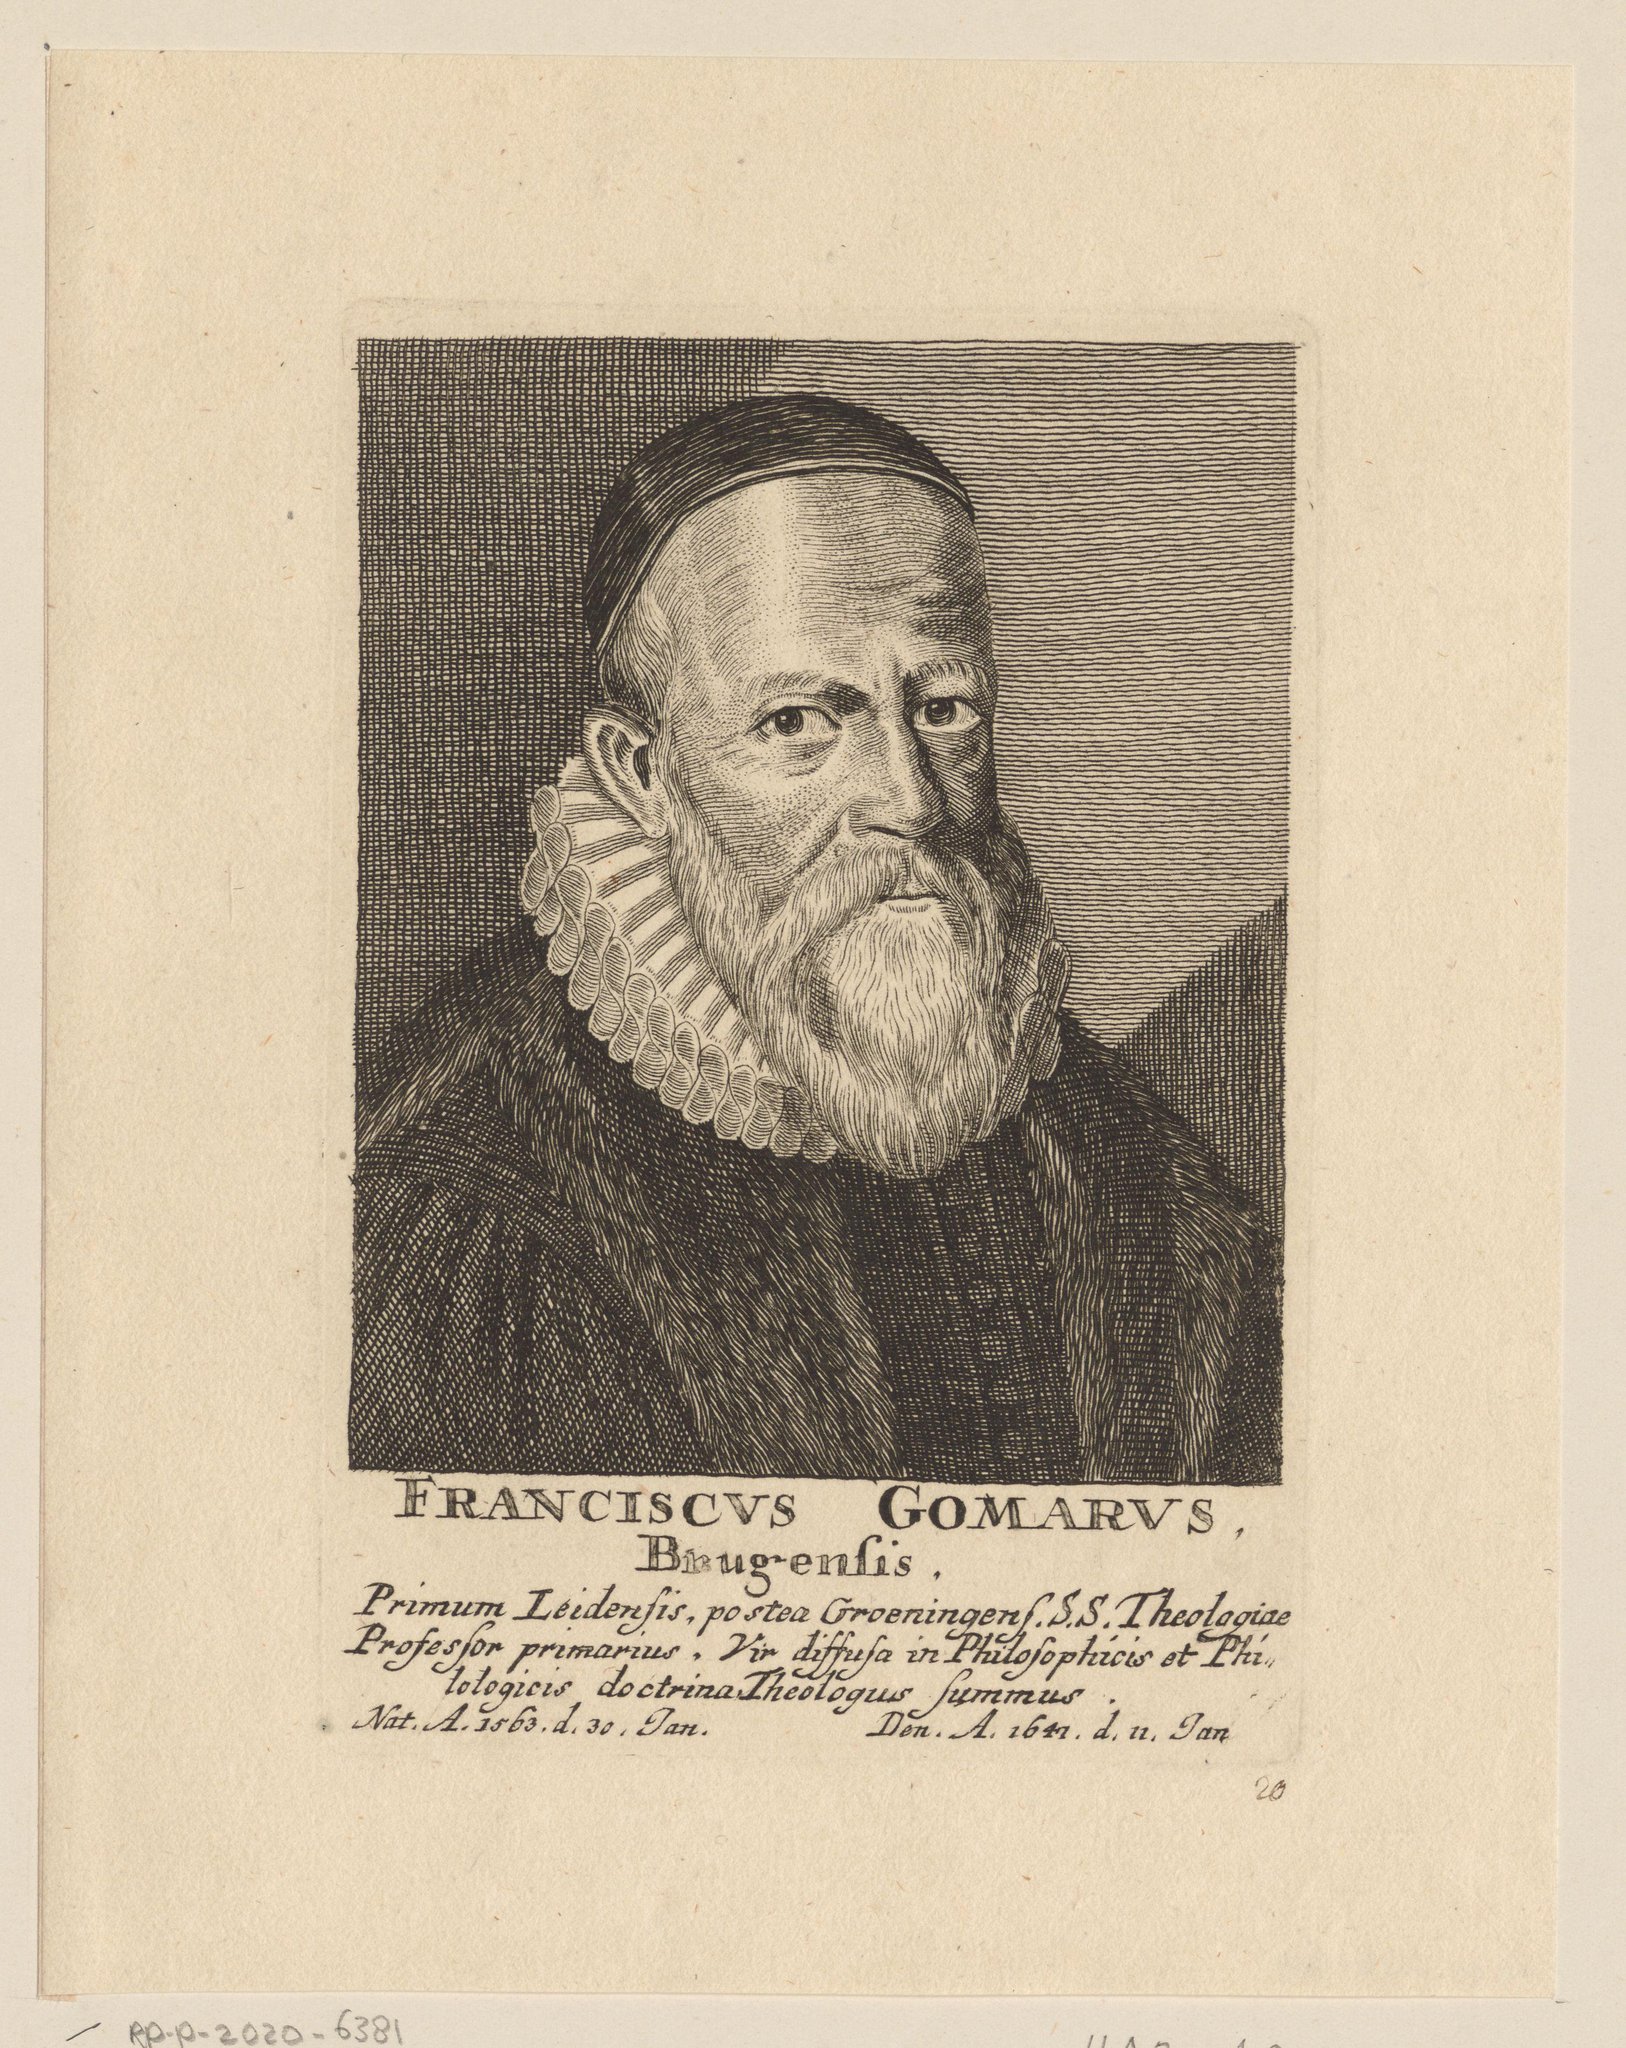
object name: print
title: Portret van Franciscus Gomarus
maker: Anonymous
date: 1641-1741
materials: paper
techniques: engraving, etching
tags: bruges, theologian, historical persons, professor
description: Prent mogelijk uit: Roth-Scholtz, Friedrich. Icones Virorum Omnium Ordinum Eruditione Omnique Item Genere. Neurenberg en Altdorf: erven Johann Daniel Taubers, 1725.